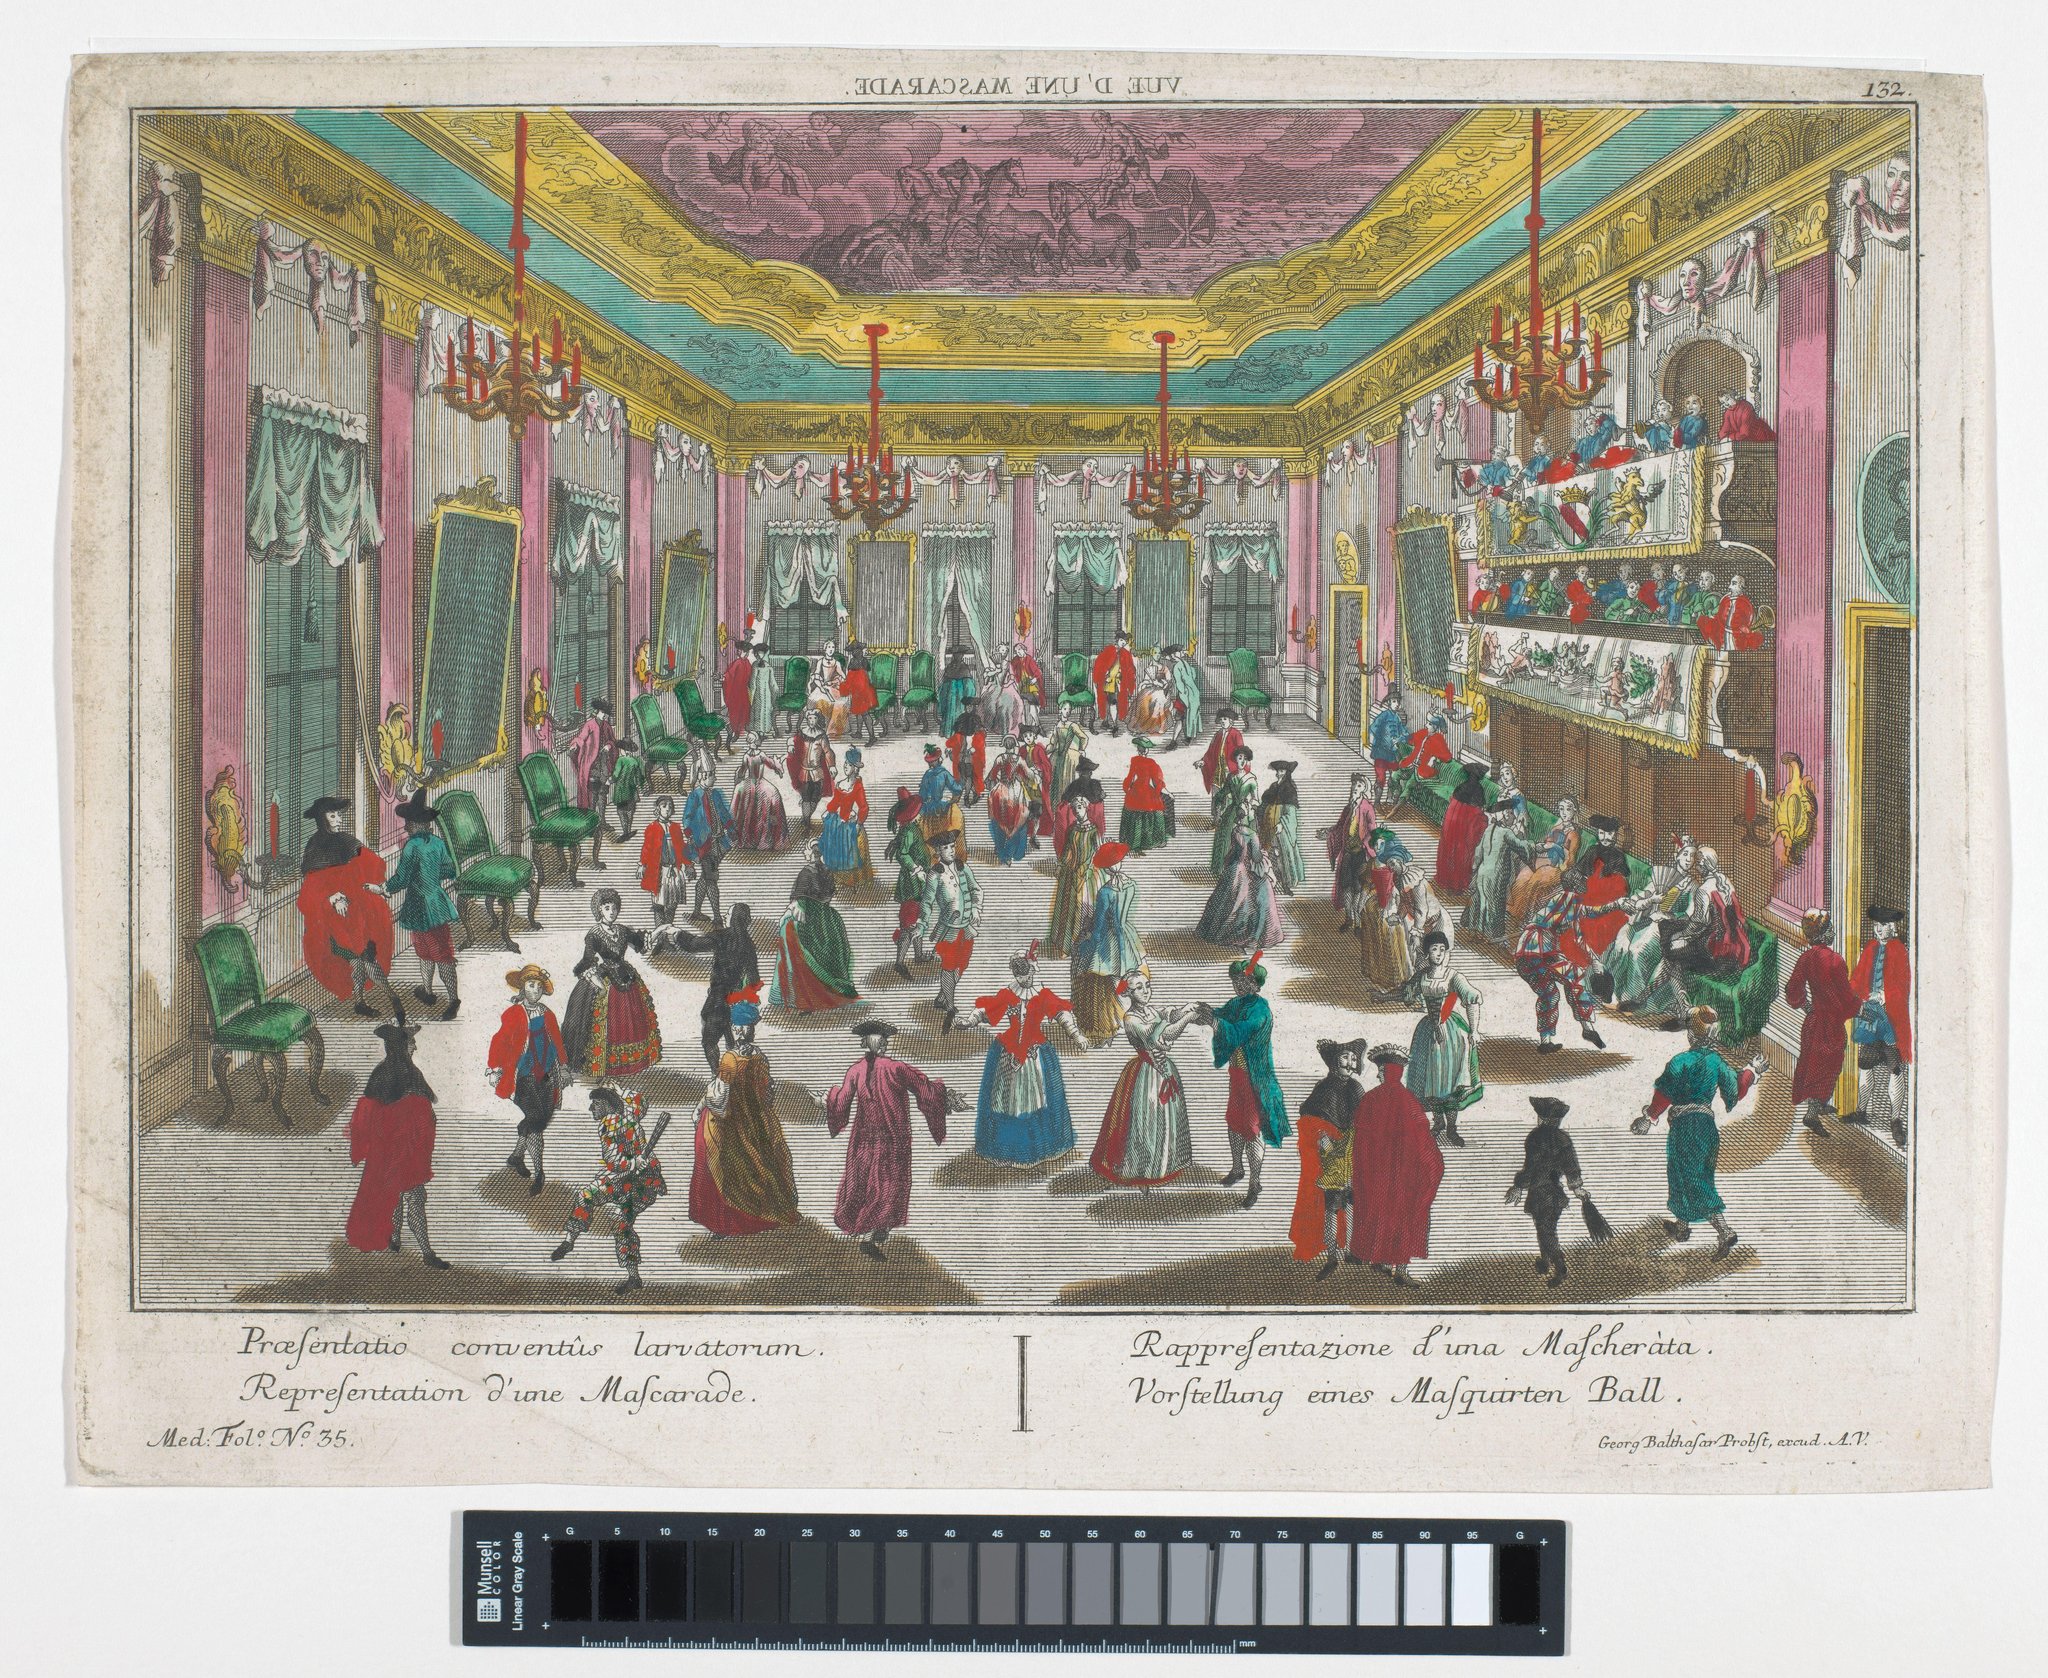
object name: print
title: Vorstellung eines Masquirten Ball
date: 1742-1801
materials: paper, watercolor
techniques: brush, etching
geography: germany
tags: masquerade, masked ball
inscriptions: collector's mark: Lugt 2233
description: De serie “Feestelijke bals”, met het nummer 35, bevat twee prenten met de nummers 131 en 132, waarvan dit nummer 132 is.